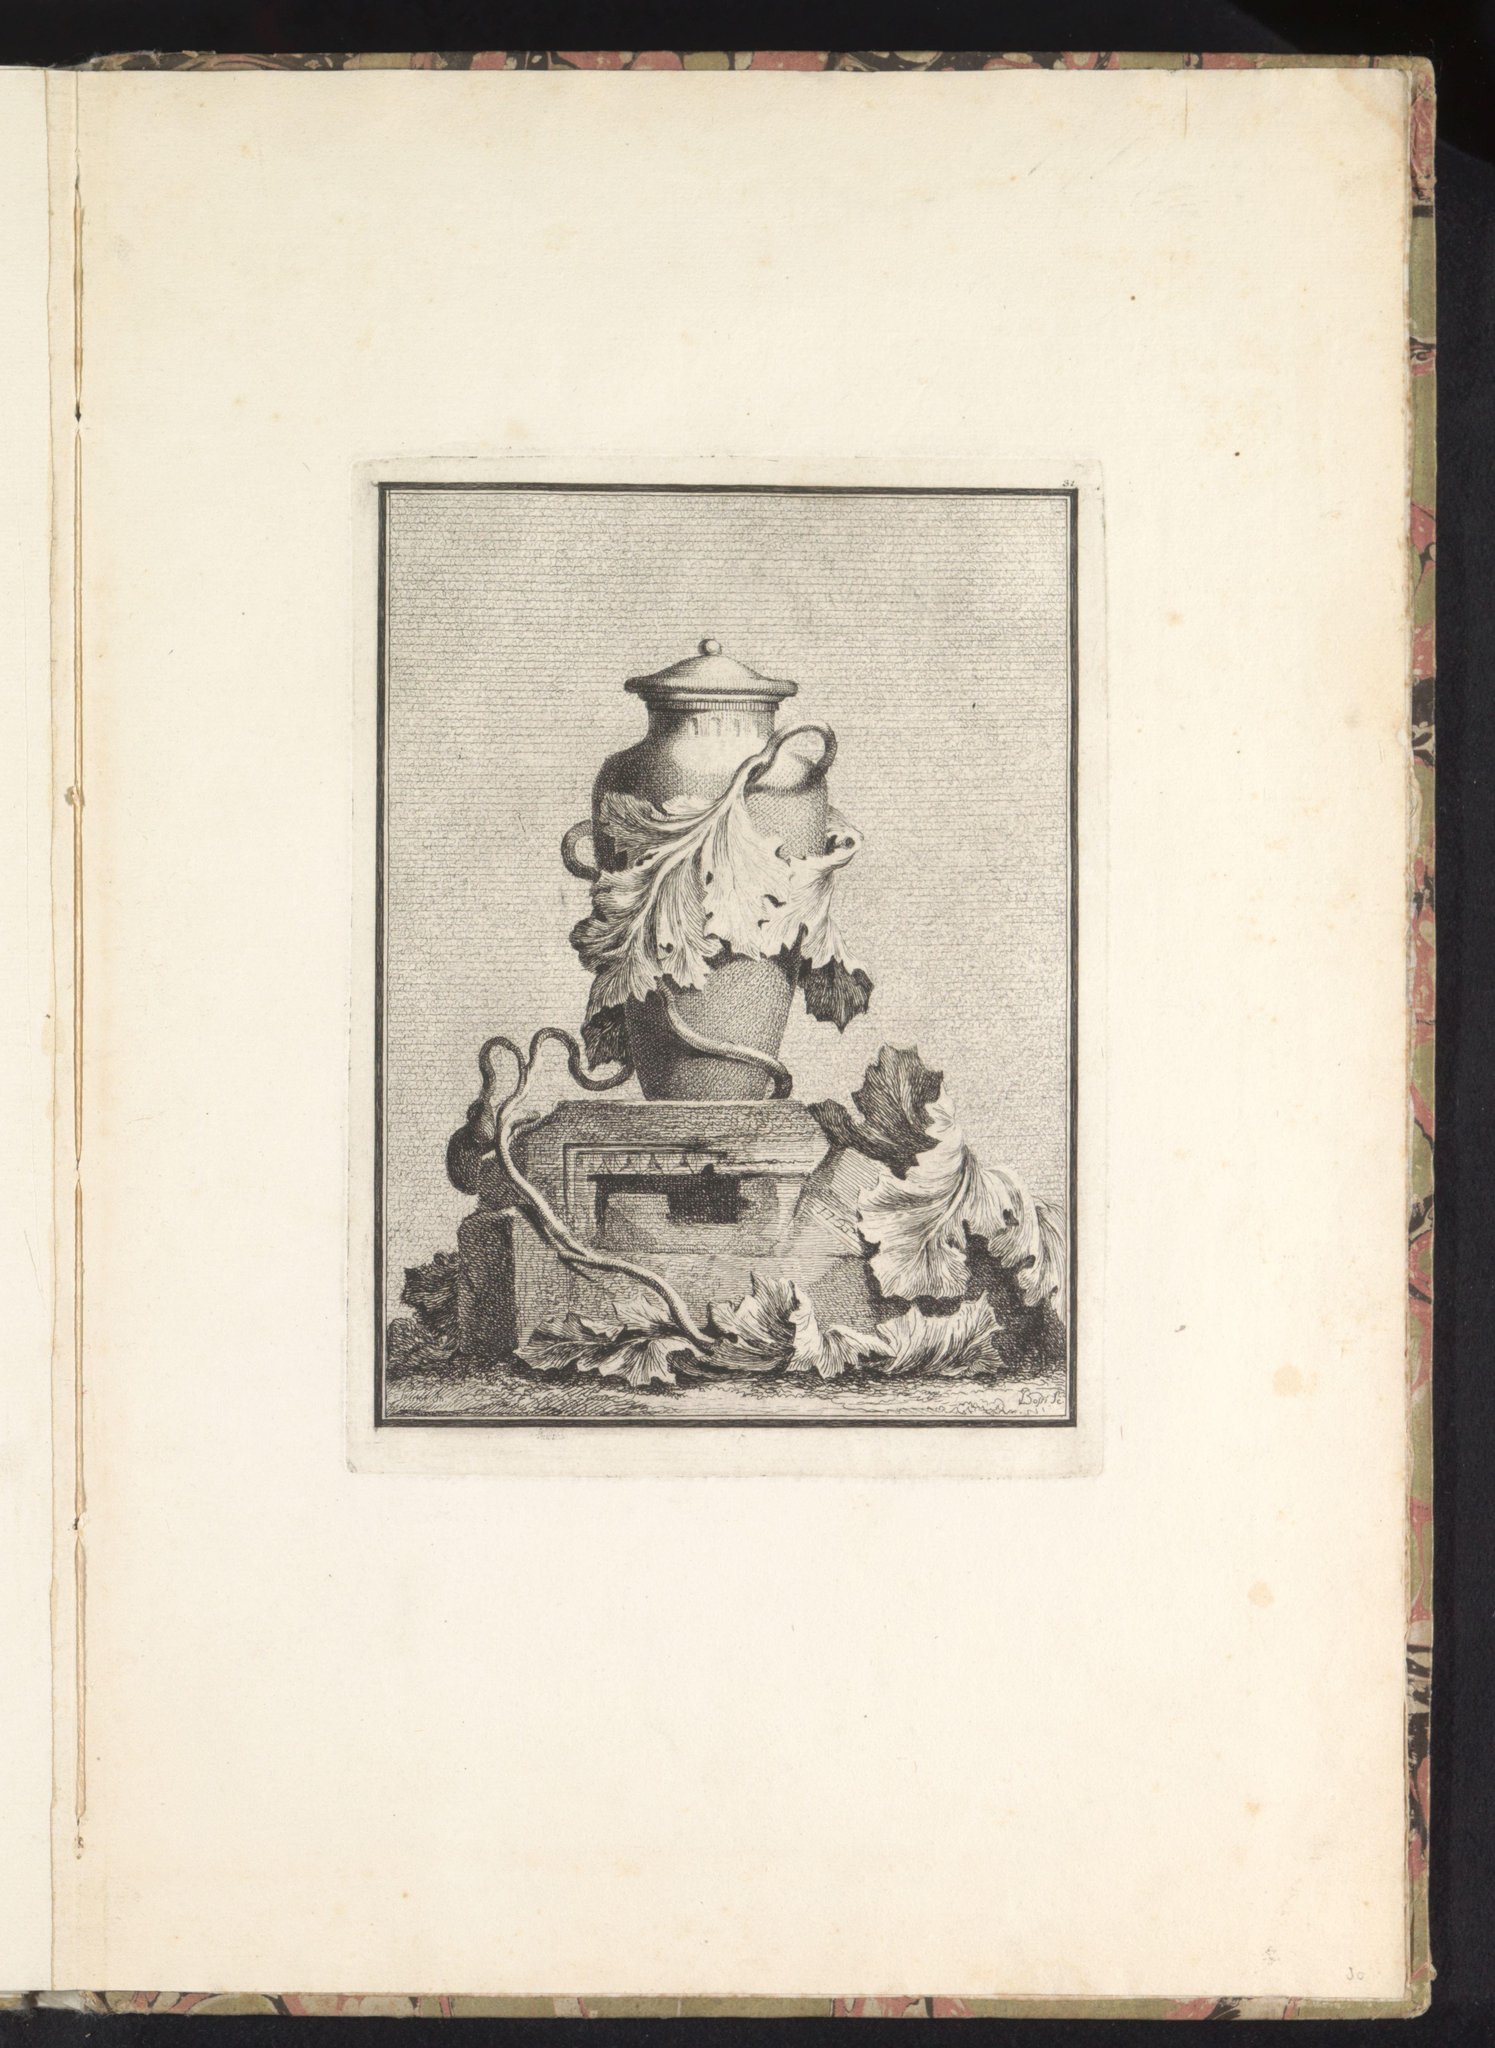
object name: ornament print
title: Ornamentele vazen uit de collectie van Guillaume du Tillot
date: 1764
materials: paper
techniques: etching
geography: parma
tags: vase ~ ornament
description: Vaas met deksel, staand op een stenen sokkel. Over de vaas en sokkel een rank van reusachtige acanthusbladeren. No. 31 uit serie van 31. Prent maakt deel uit van een album. Gedrukt recto rechtsboven: 31.